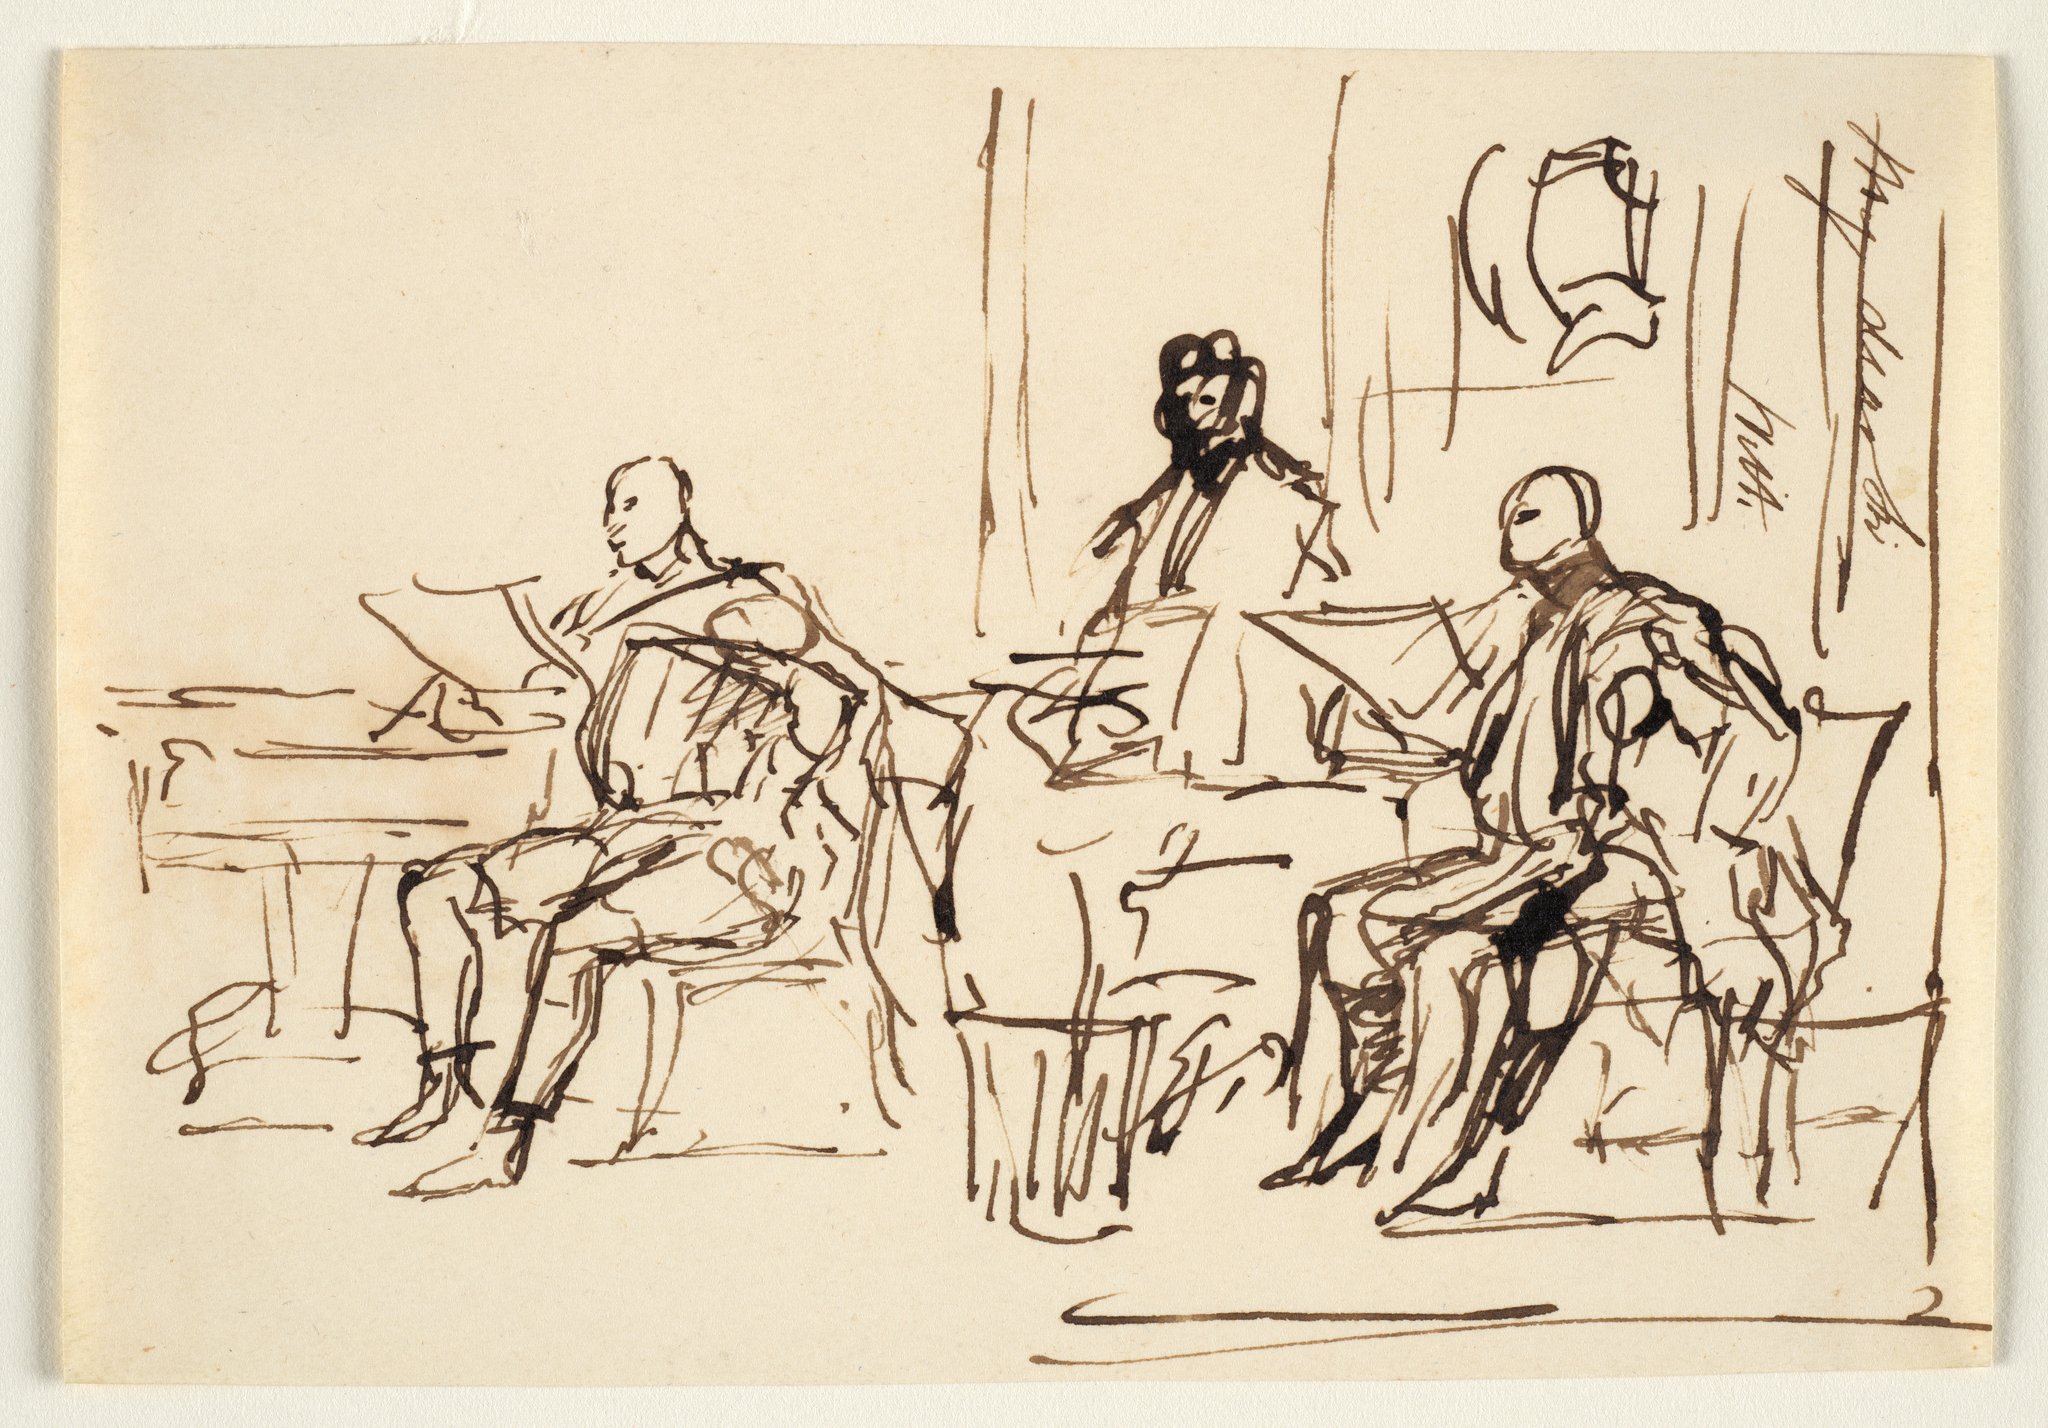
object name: drawing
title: Studies for "Frederick, Duke of York and Albany"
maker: sir david wilkie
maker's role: artist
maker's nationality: british, scottish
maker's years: 1785-1841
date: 1822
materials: ink, paper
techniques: pen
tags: men